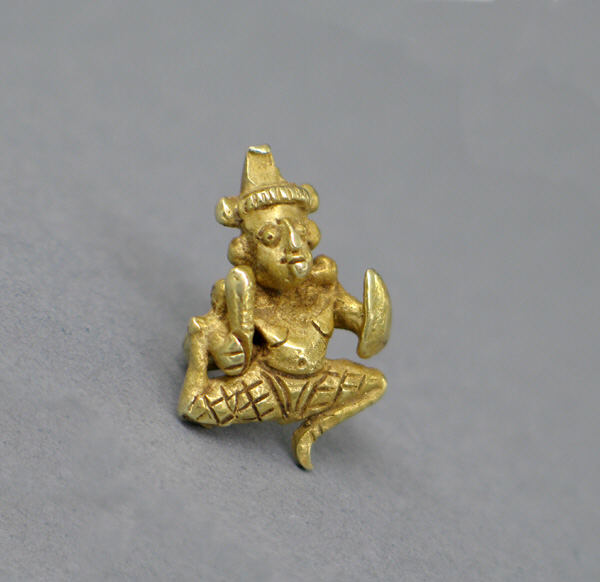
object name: ear ornament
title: Ear Ornament with Image of Visnu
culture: indonesian, javanese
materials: gold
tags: vishnu